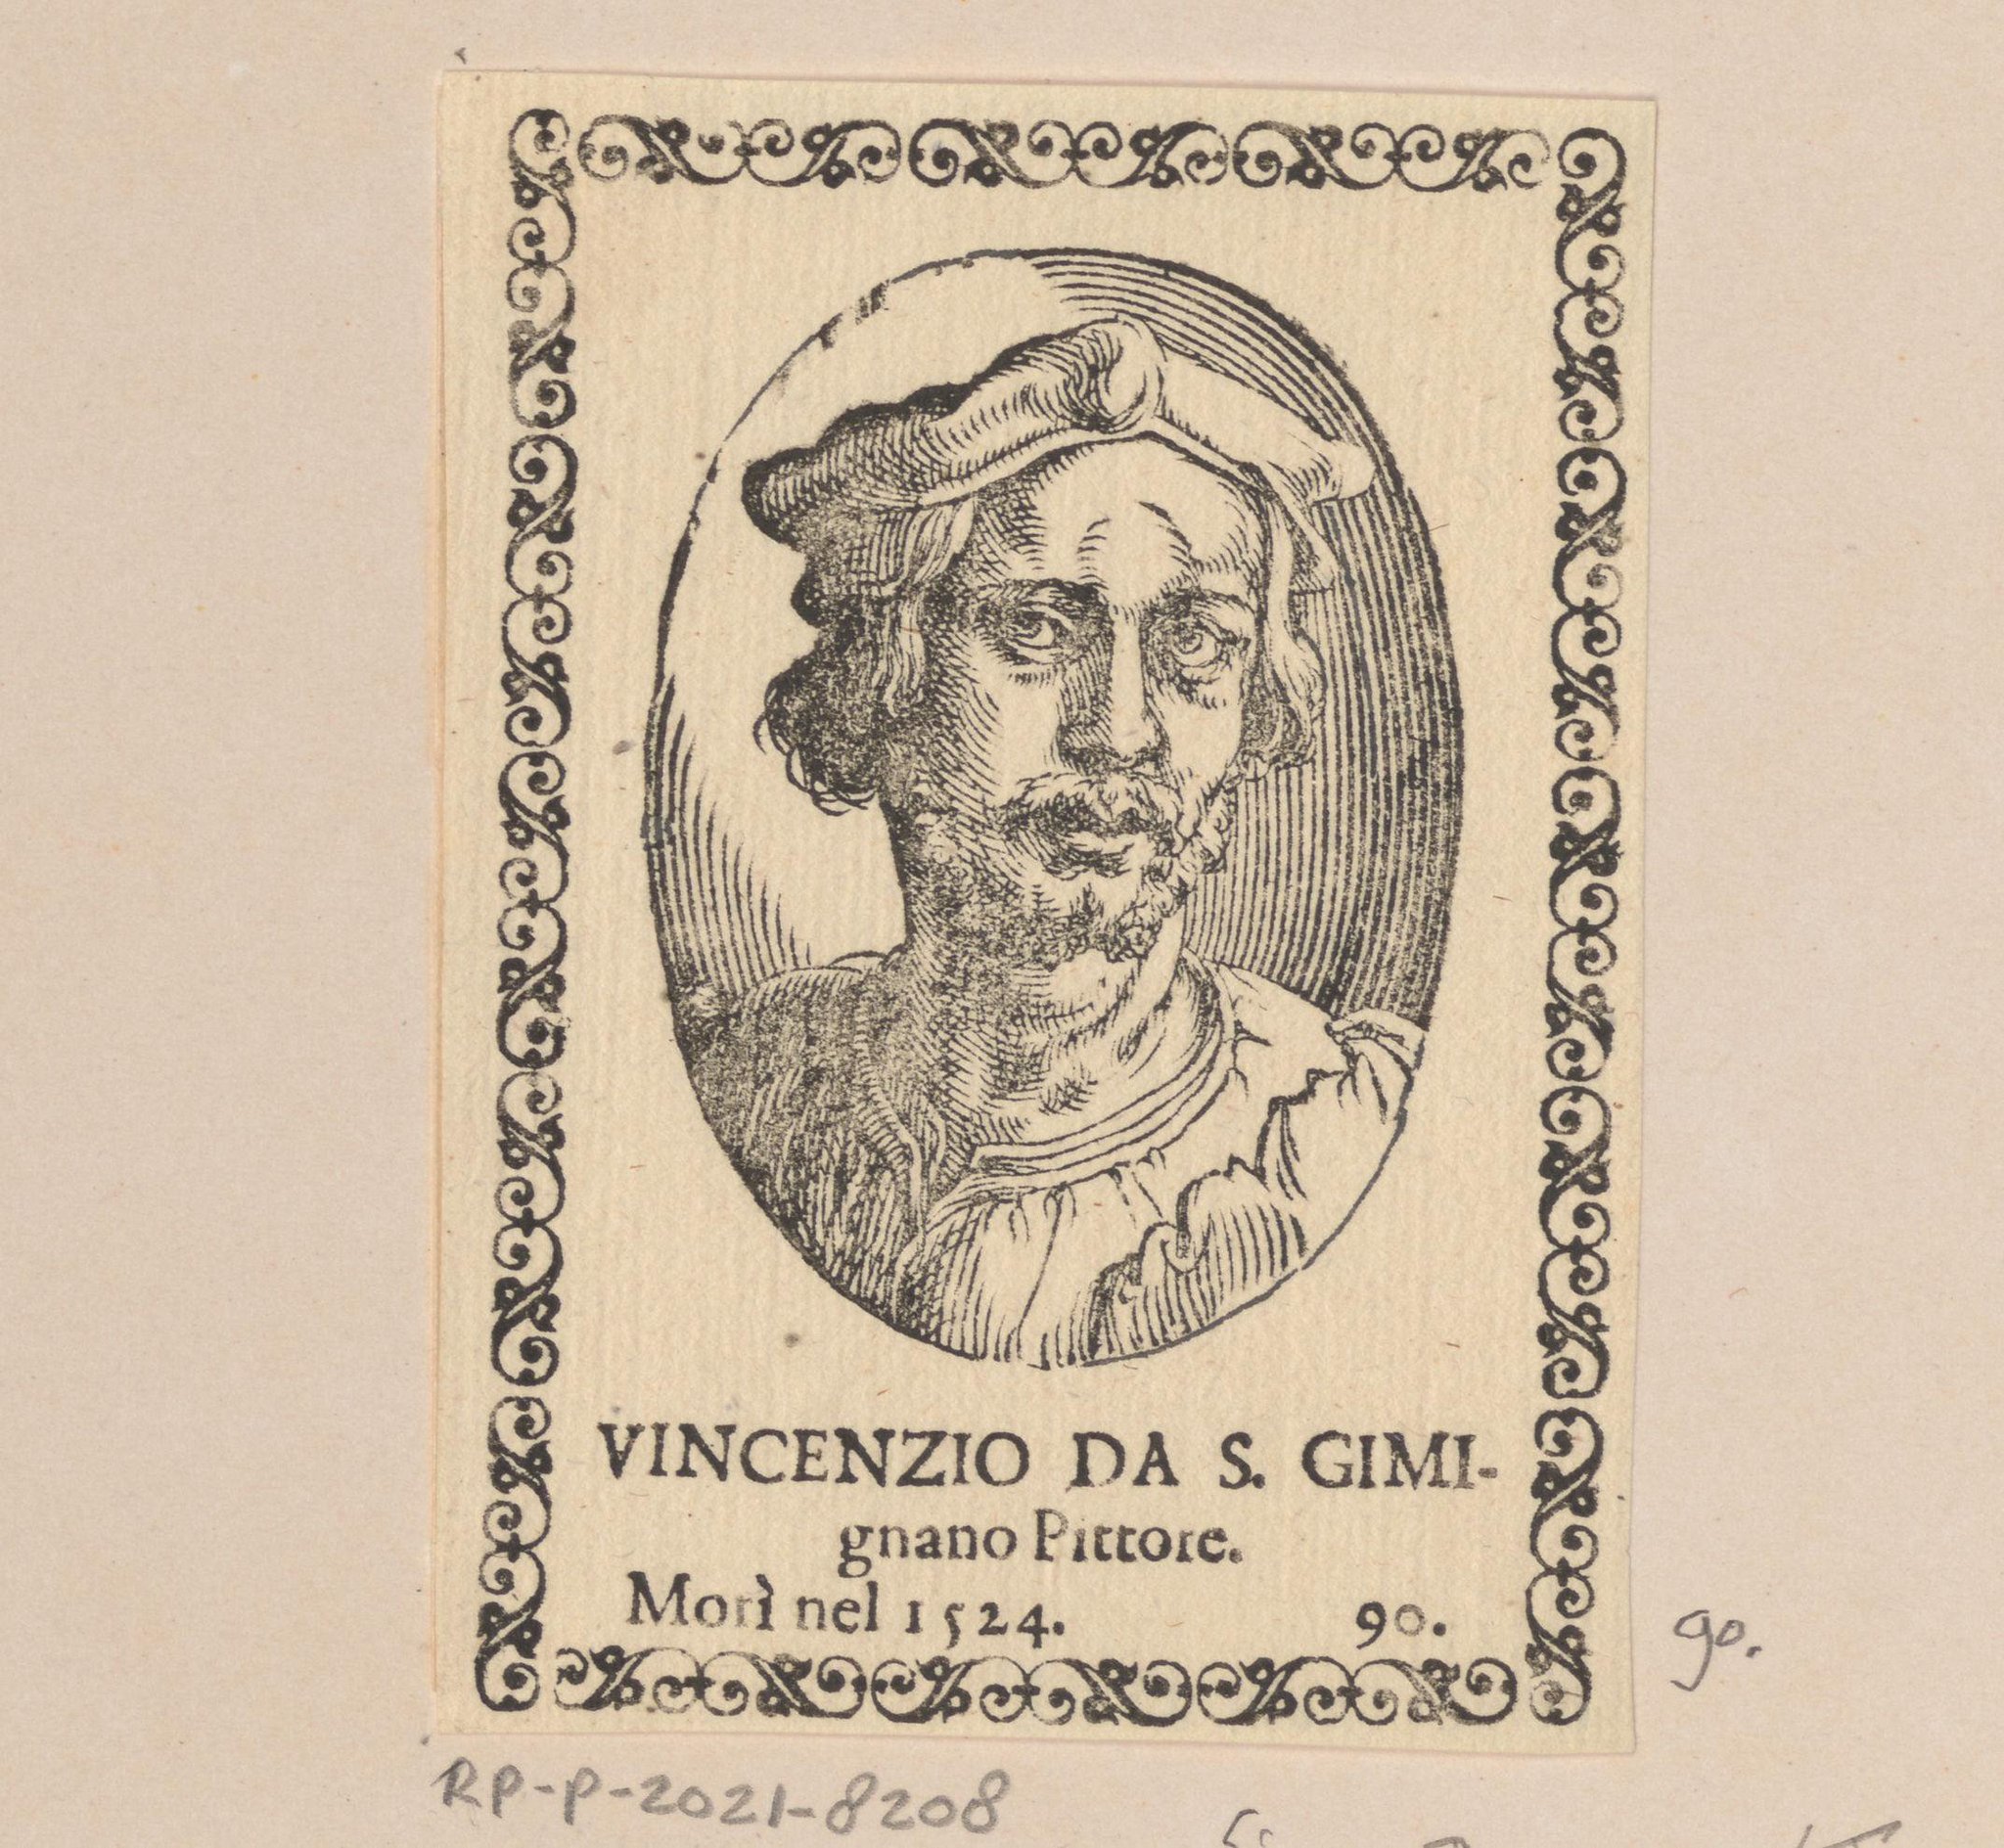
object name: print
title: Portret van Giuliano da Sangallo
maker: cristoforo coriolano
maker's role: print maker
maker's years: 1540-1610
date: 1568-1650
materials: paper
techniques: letterpress printing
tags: draughtsman, vincenzo tamagni da san gimignano, historical persons, portrait, self-portrait of painter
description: Prent komt uit een editie van Vasari's 'Vite'. Prent met een andere omlijsting gebruikt in: Vasari, Giorgio. Le vite de' piu eccellenti pittori scultori, e architettori. Florence: Filippo Giunta, 1568. En mogelijk in de editie uit 1647.